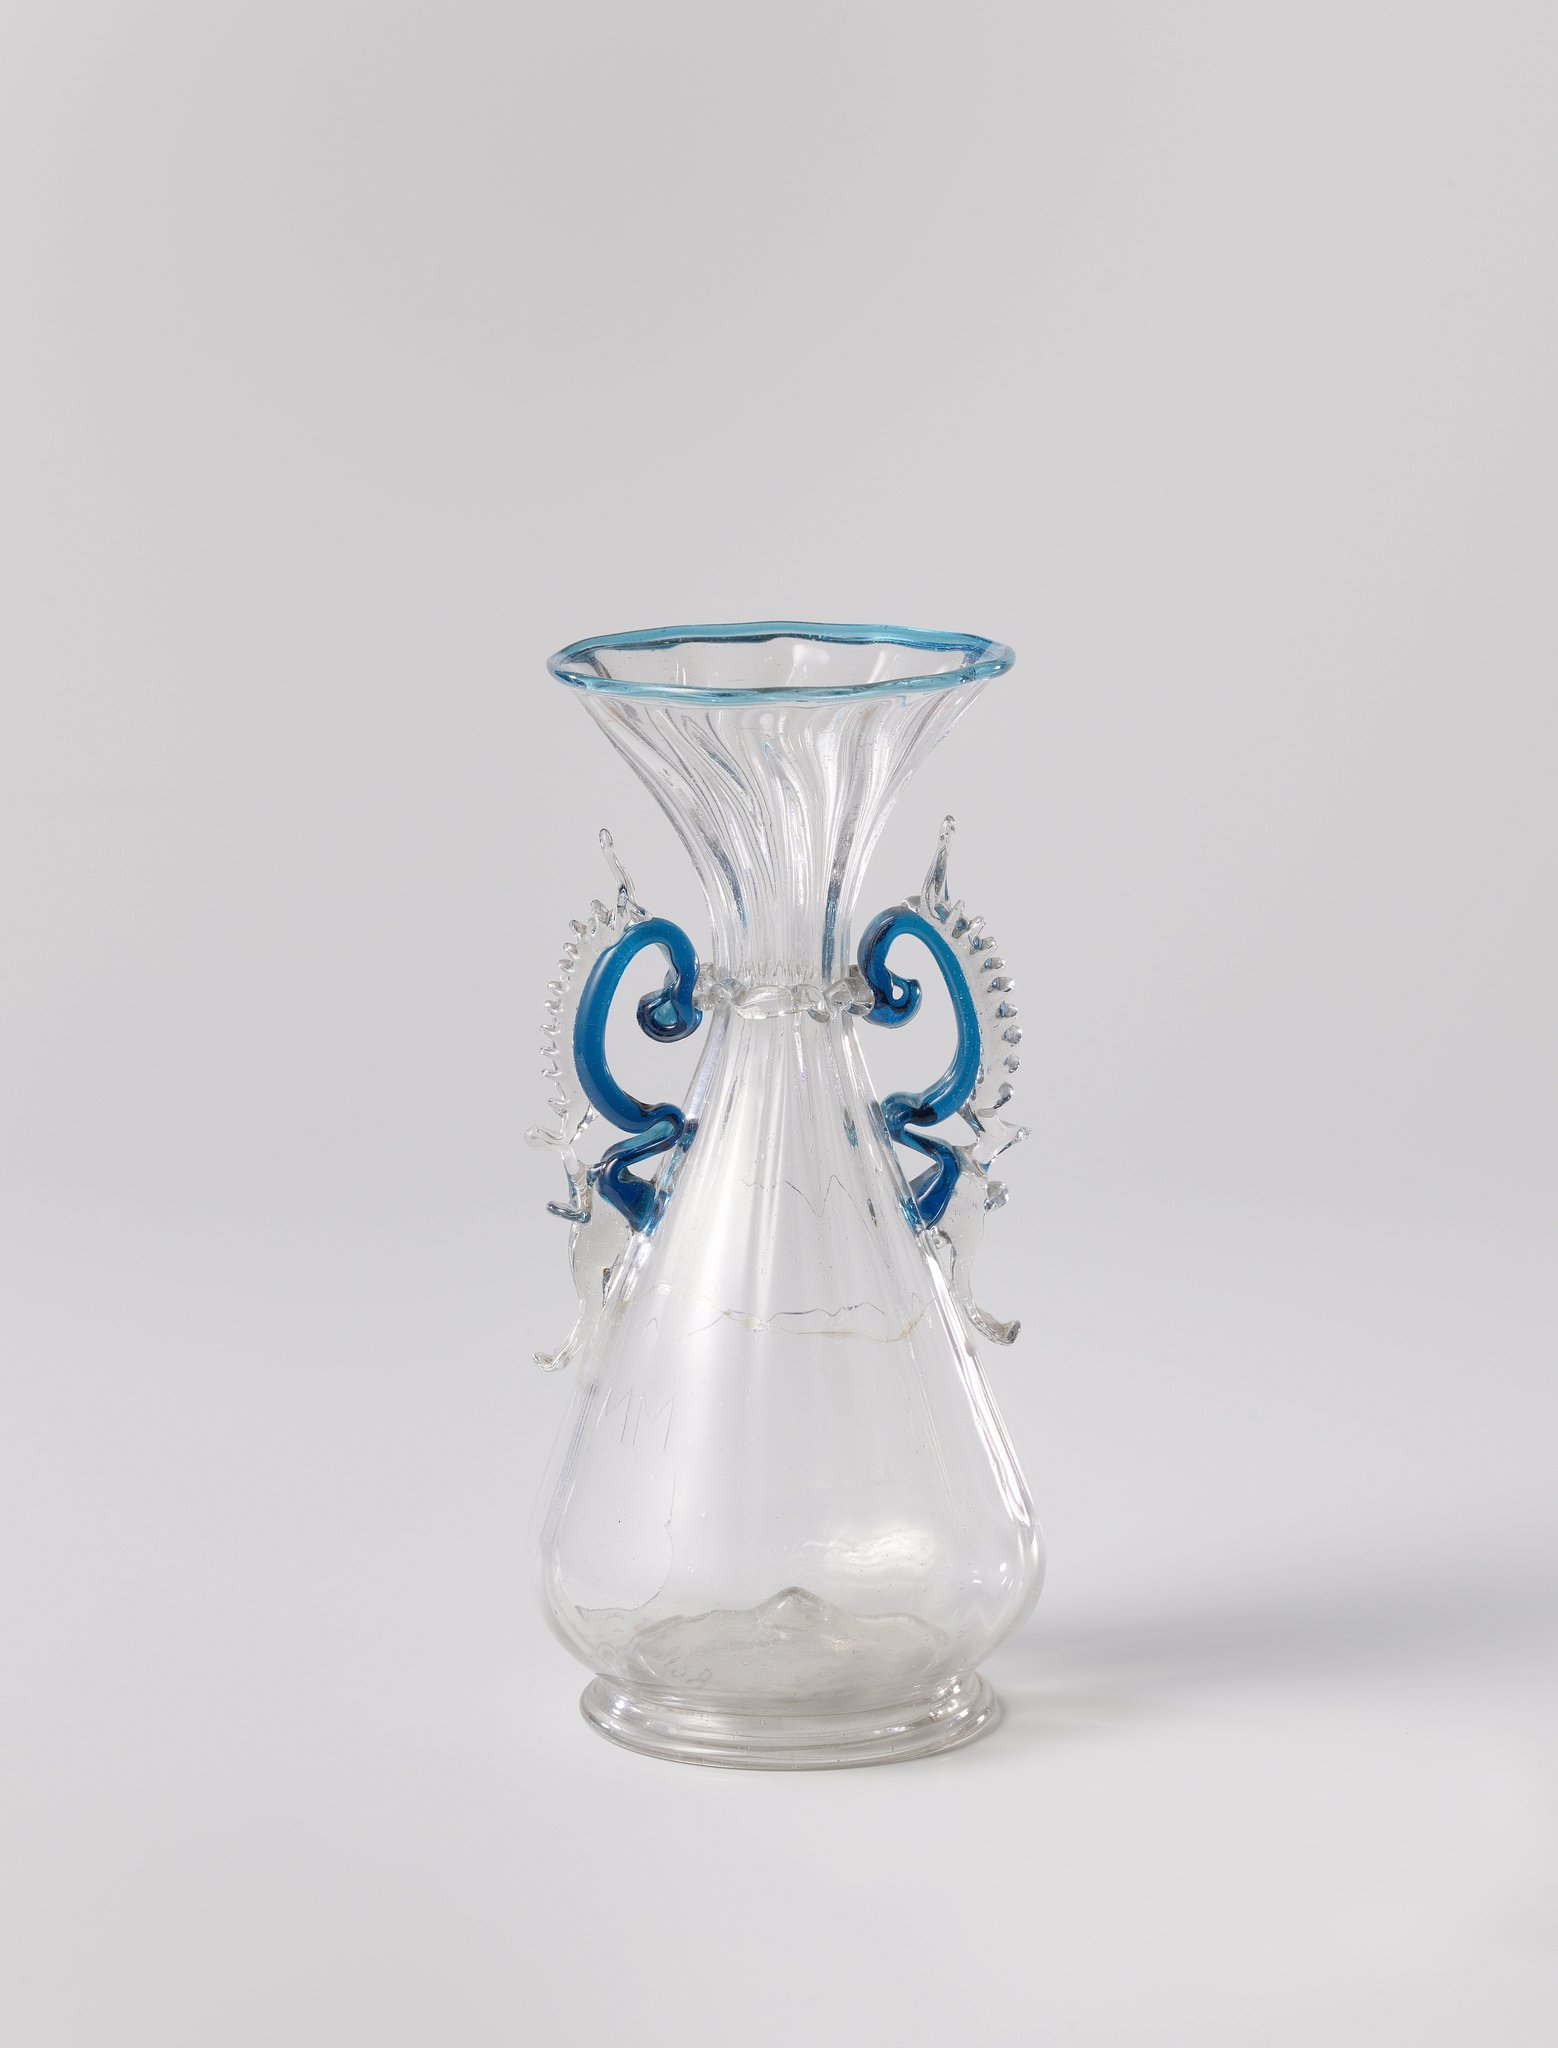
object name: carafe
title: Karaf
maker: Anonymous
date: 1600-1700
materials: glass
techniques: glassblowing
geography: venice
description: Karaf met ingestoken bodem, gladde standring. Conisch lichaam en trompetvormige mond, optisch in flauwe ribben geblazen. Om de hals een gegolfde draad. Twee vleugels in de vorm van zeepaarden, van kleurloos en blauw glas